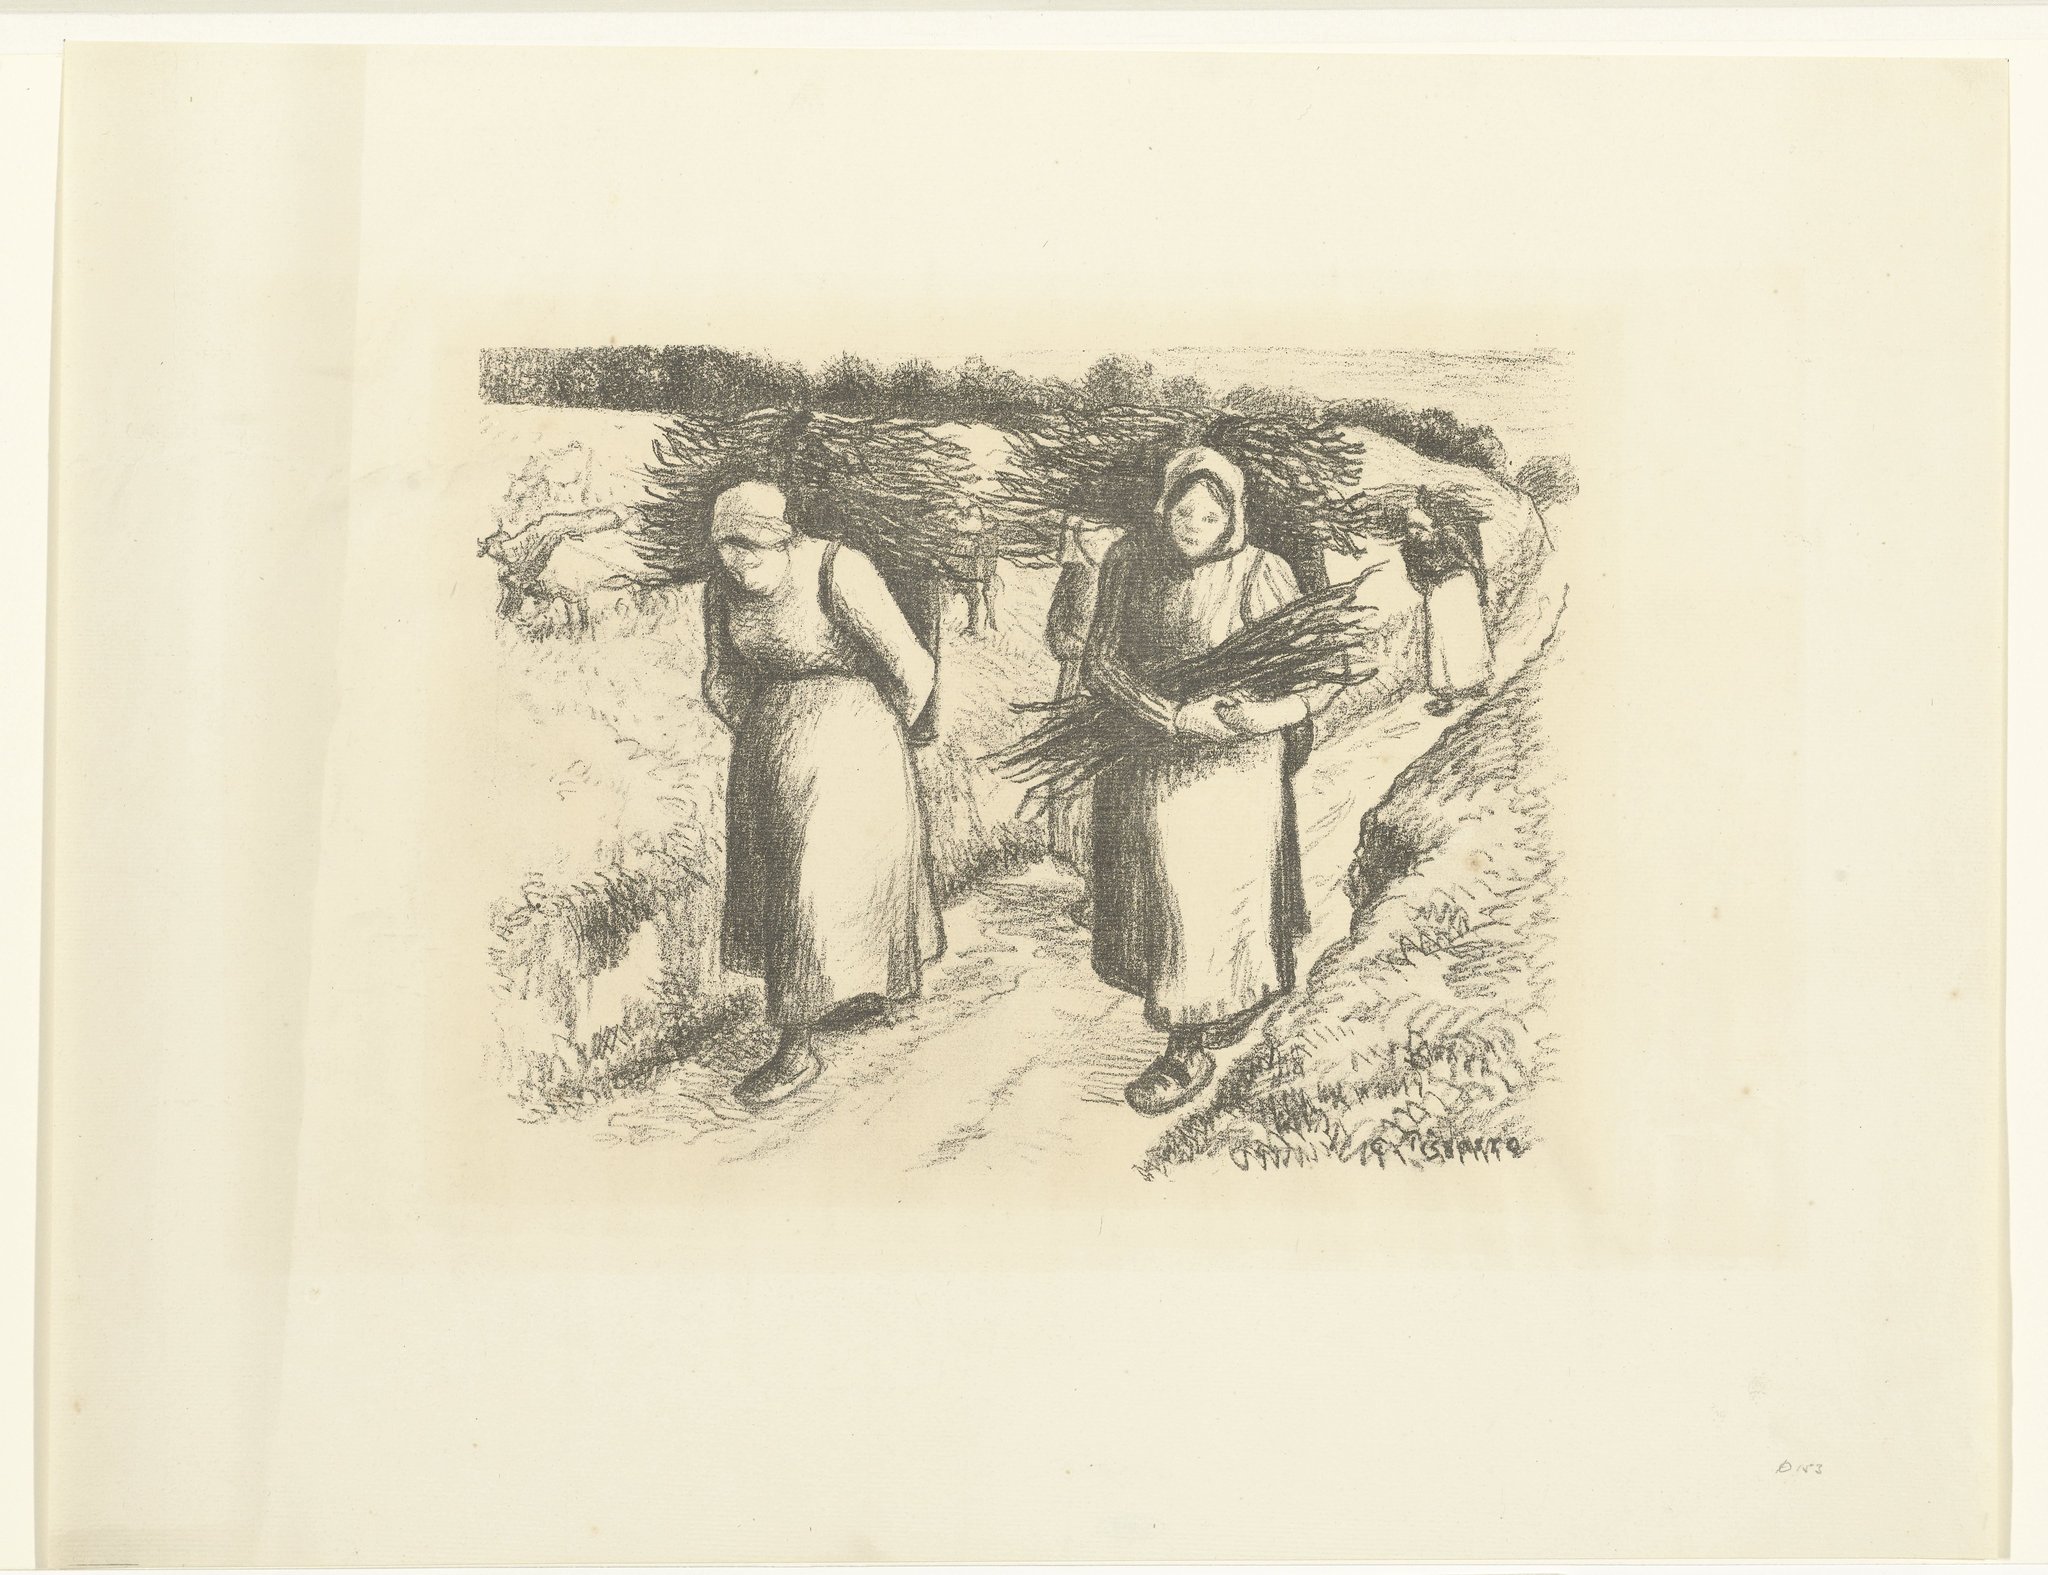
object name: print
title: Vrouwen dragen takkenbossen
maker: camille jacob pissarro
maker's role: draughtsman, print maker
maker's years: 1830-1903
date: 1896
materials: paper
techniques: lithograph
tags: woodgathering, woodgatherer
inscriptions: collector's mark: Lugt 2228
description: Vier vrouwen hebben hout gesprokkeld en lopen met manden vol takkenbossen op hun rug op een weg langs weiden.